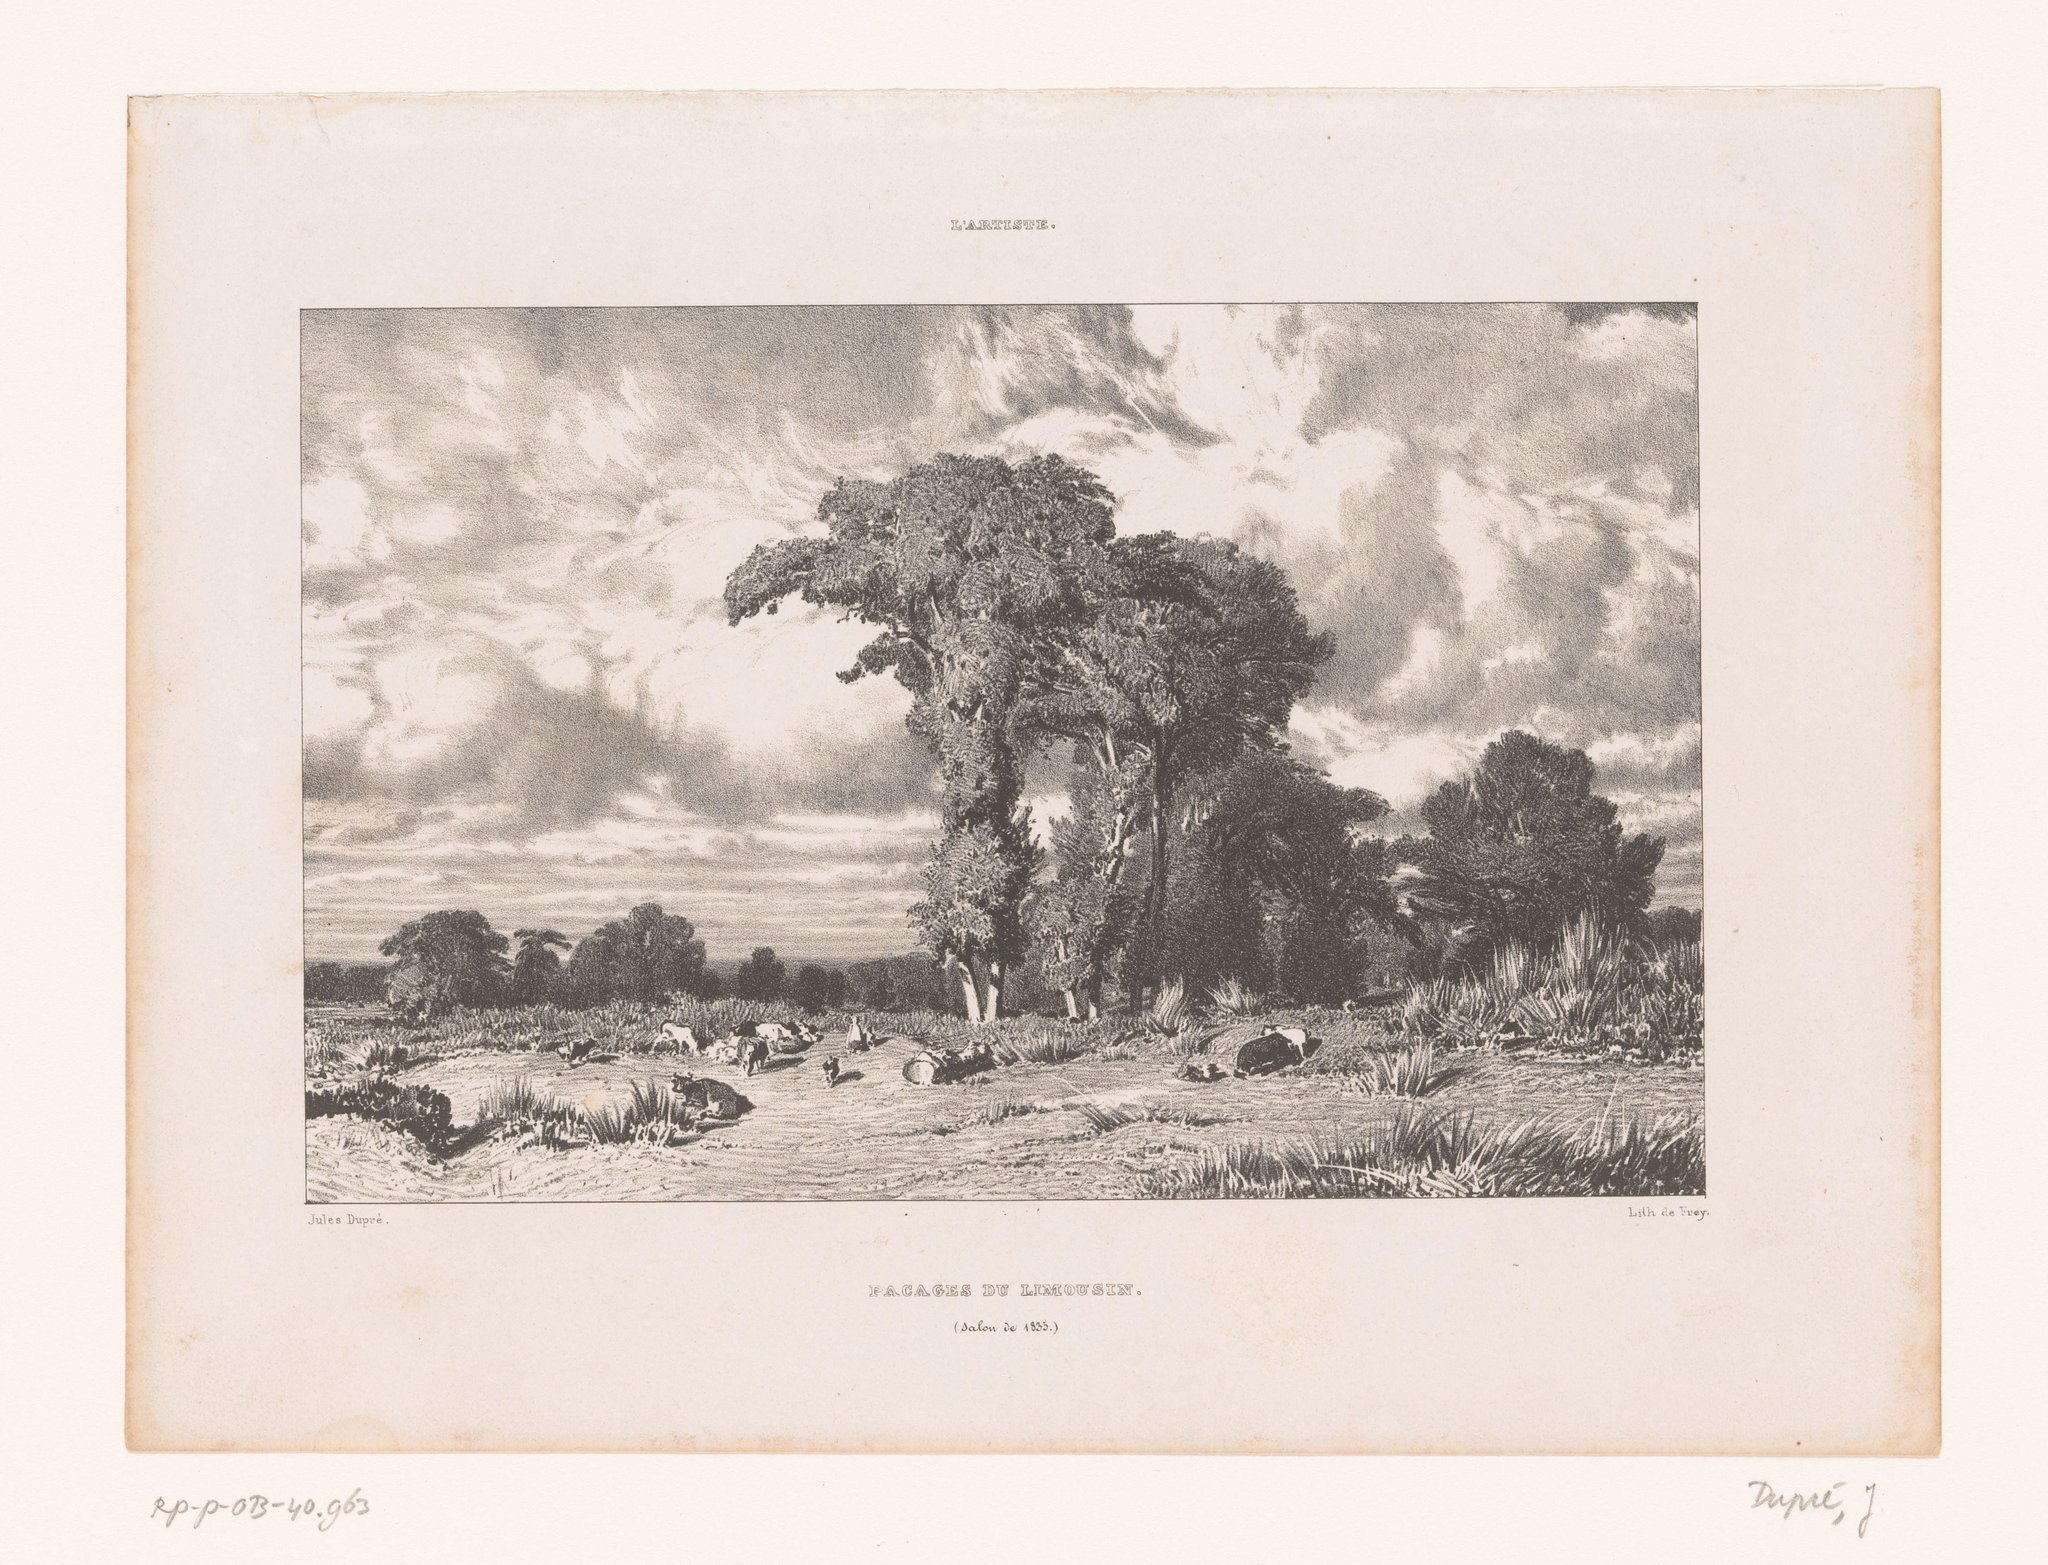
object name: print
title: Weilanden met koeien in de Limousin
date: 1835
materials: paper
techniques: lithograph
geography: paris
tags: cow, meadow, pasture (+ landscape with figures, staffage)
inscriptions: date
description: Prent gebruikt voor: L'Artiste, journal de la littérature et des beaux-arts, 1835.